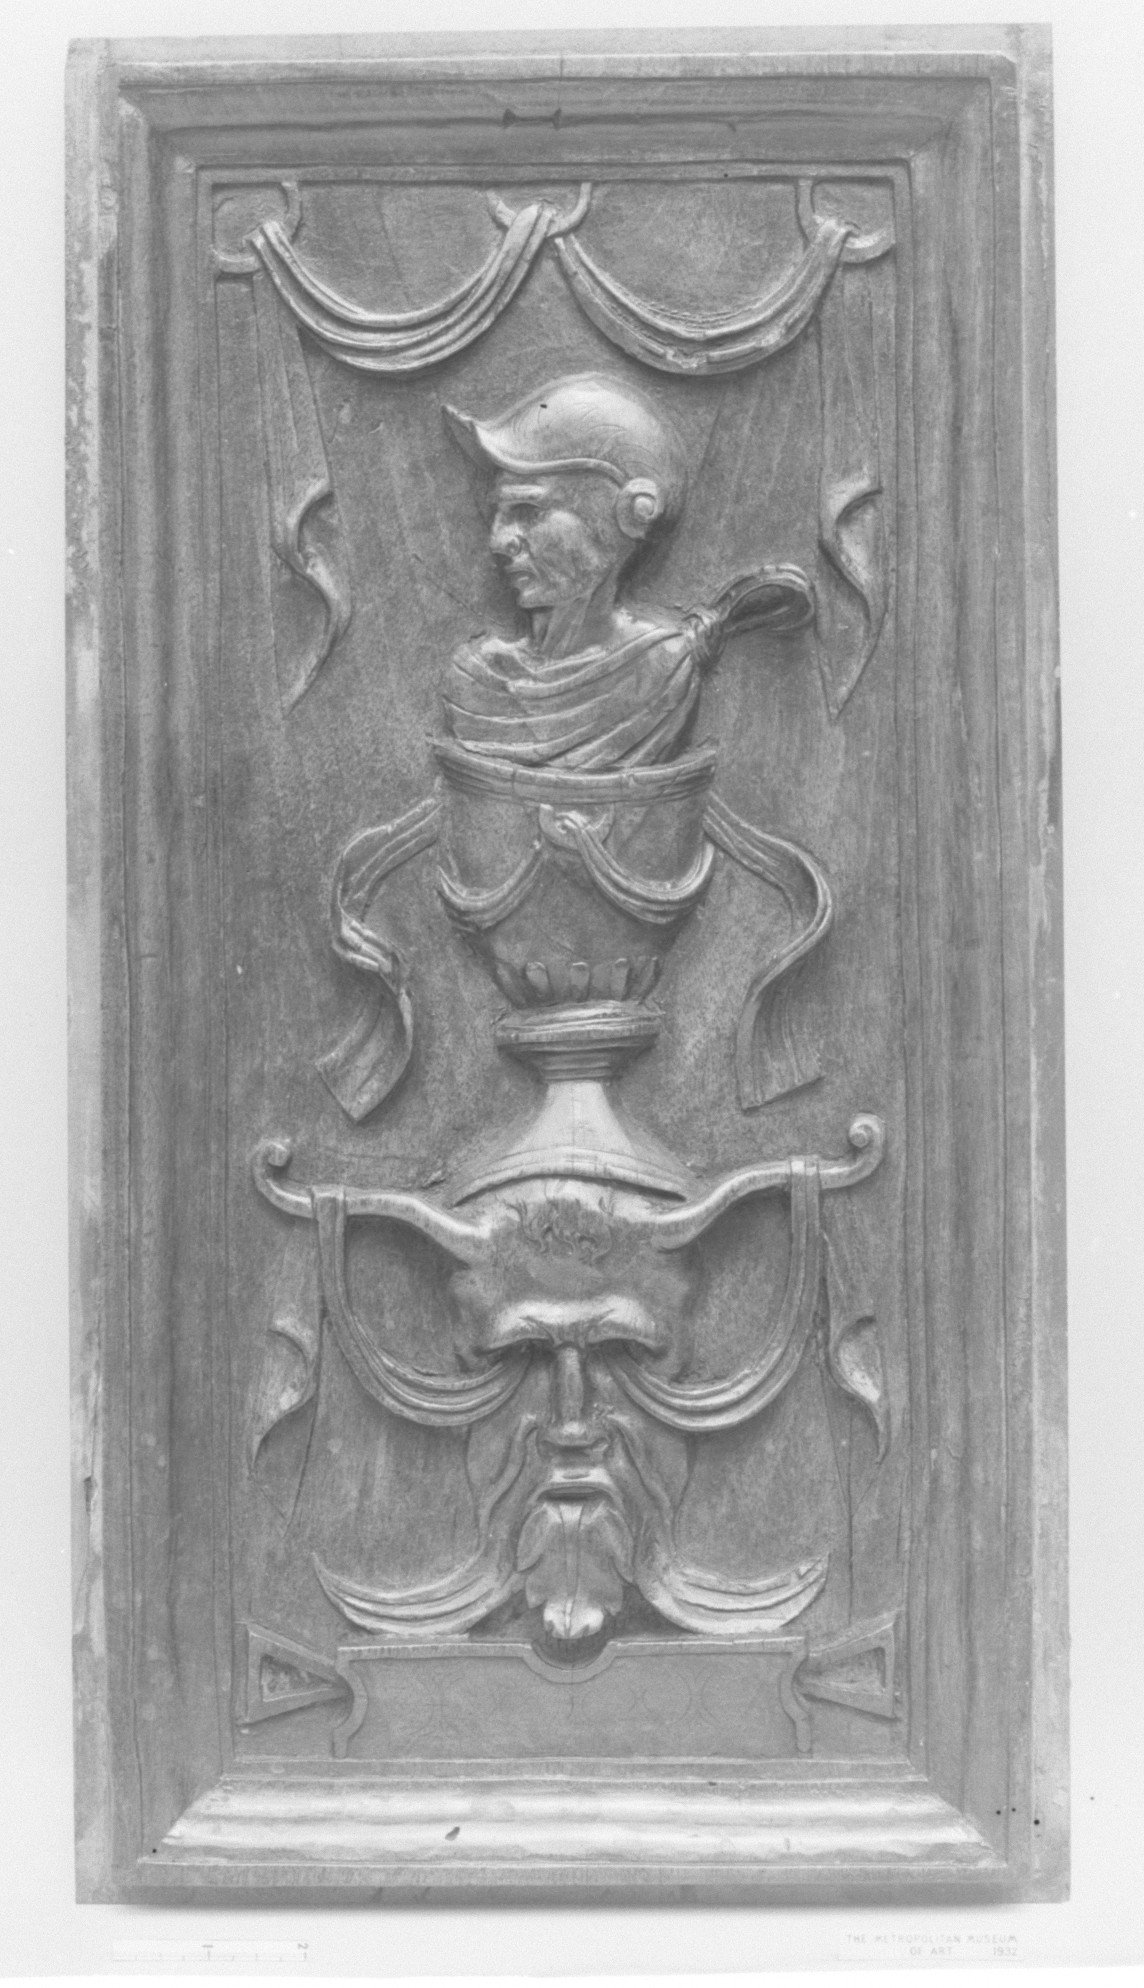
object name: panel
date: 1501-1600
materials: wood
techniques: carving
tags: men,profiles